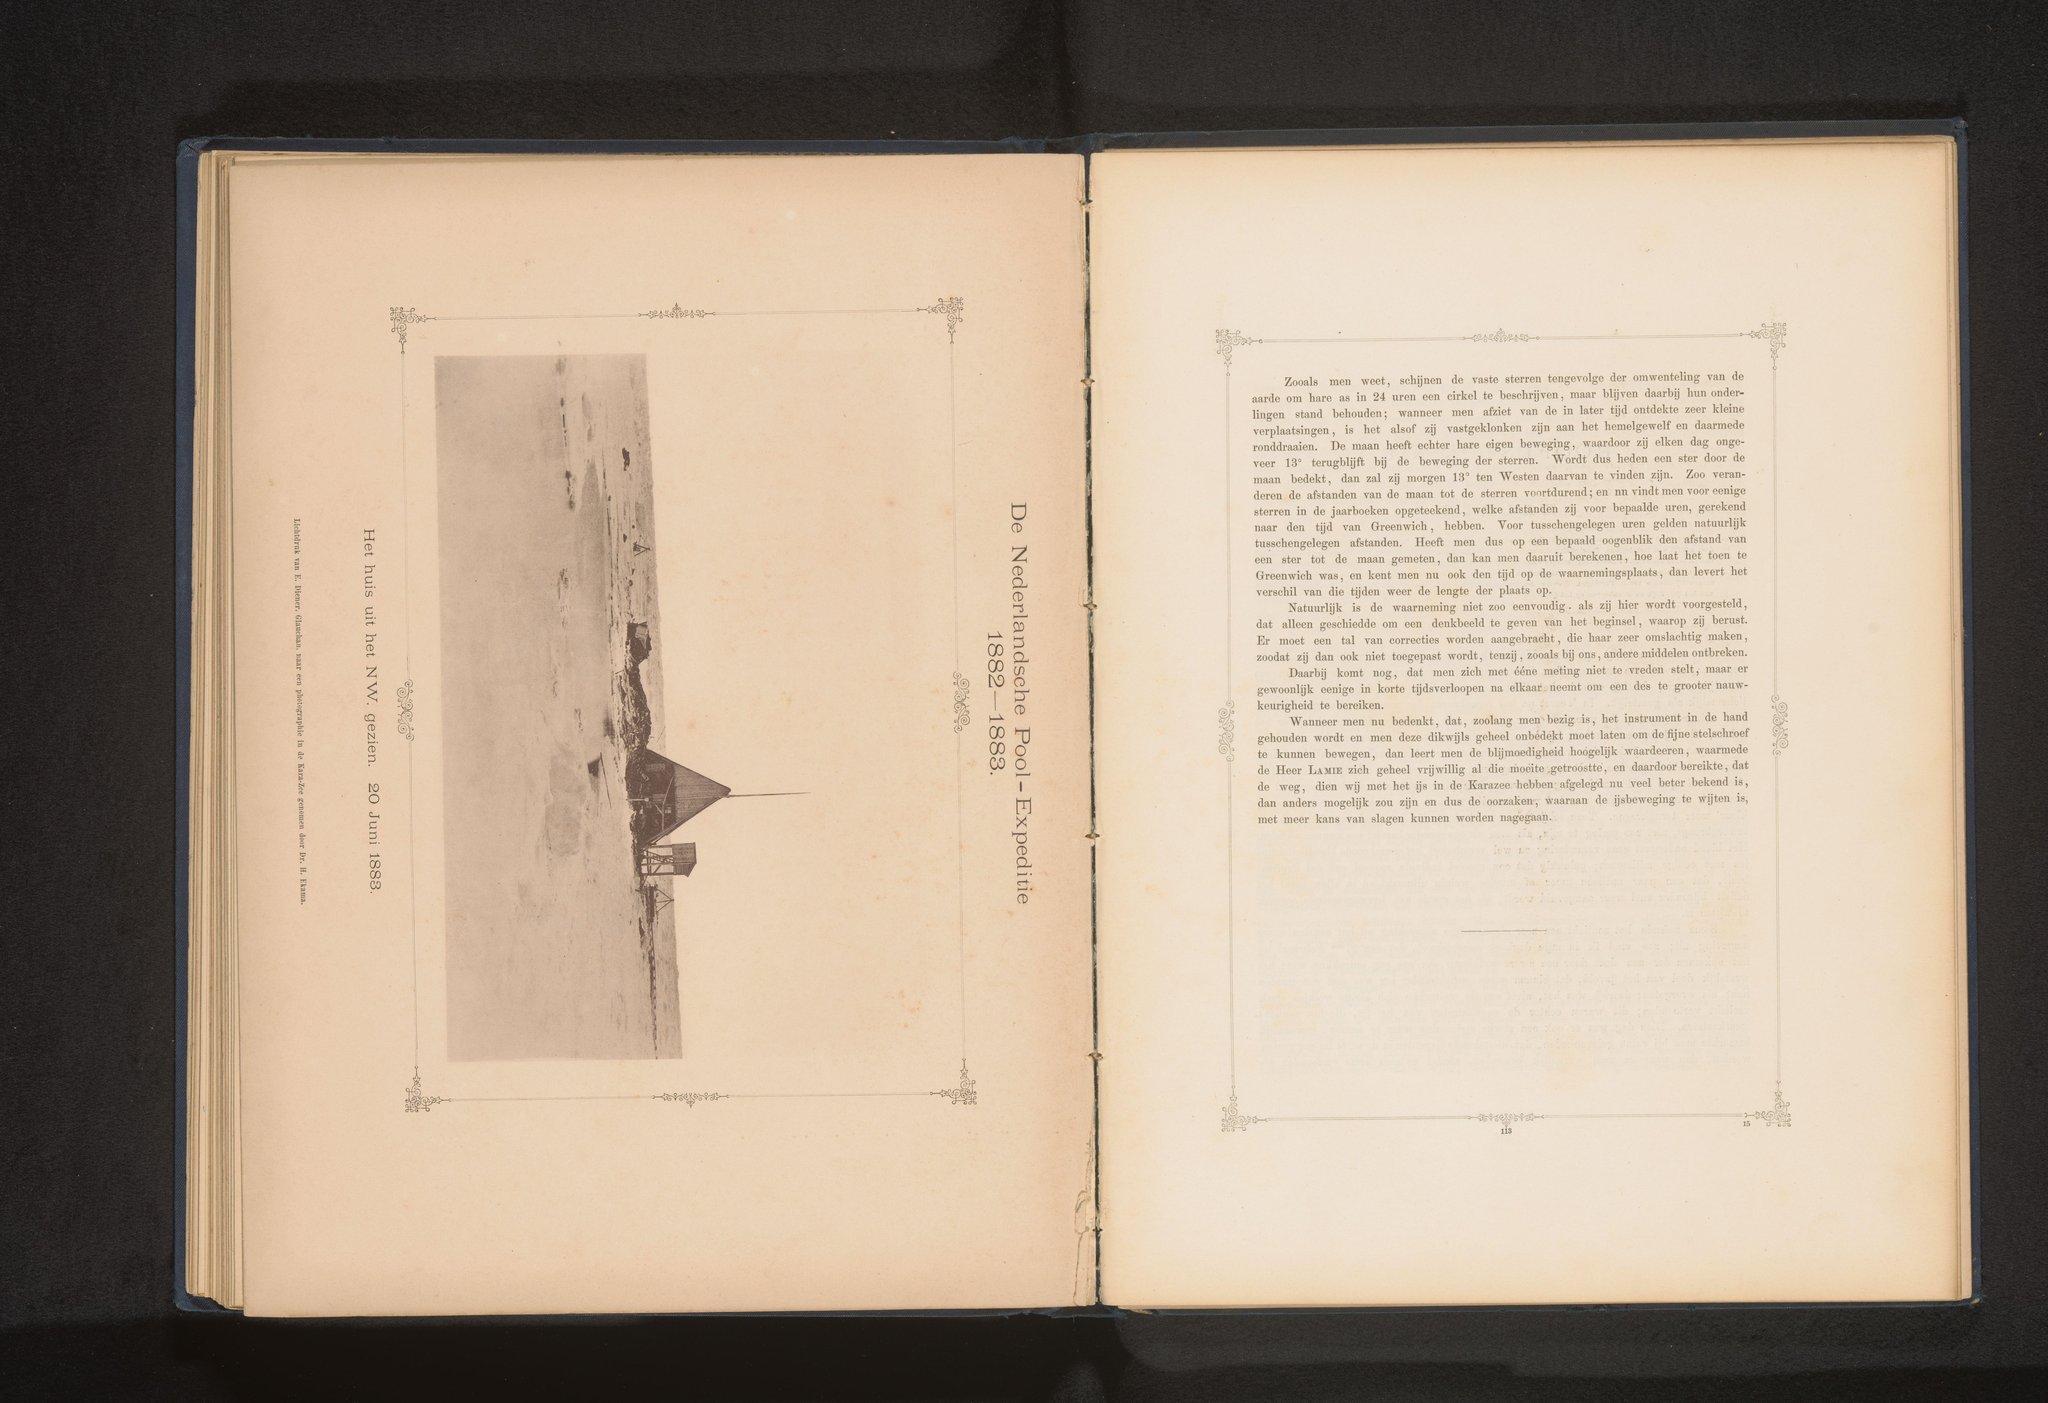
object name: page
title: Gezicht op een huis op de Karazee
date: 1881-1886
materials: paper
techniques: photograph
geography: kara sea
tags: icefield, landscapes in polar regions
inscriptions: inscription: ‘De Nederlandsche Pool-Expeditie 1882-1883’